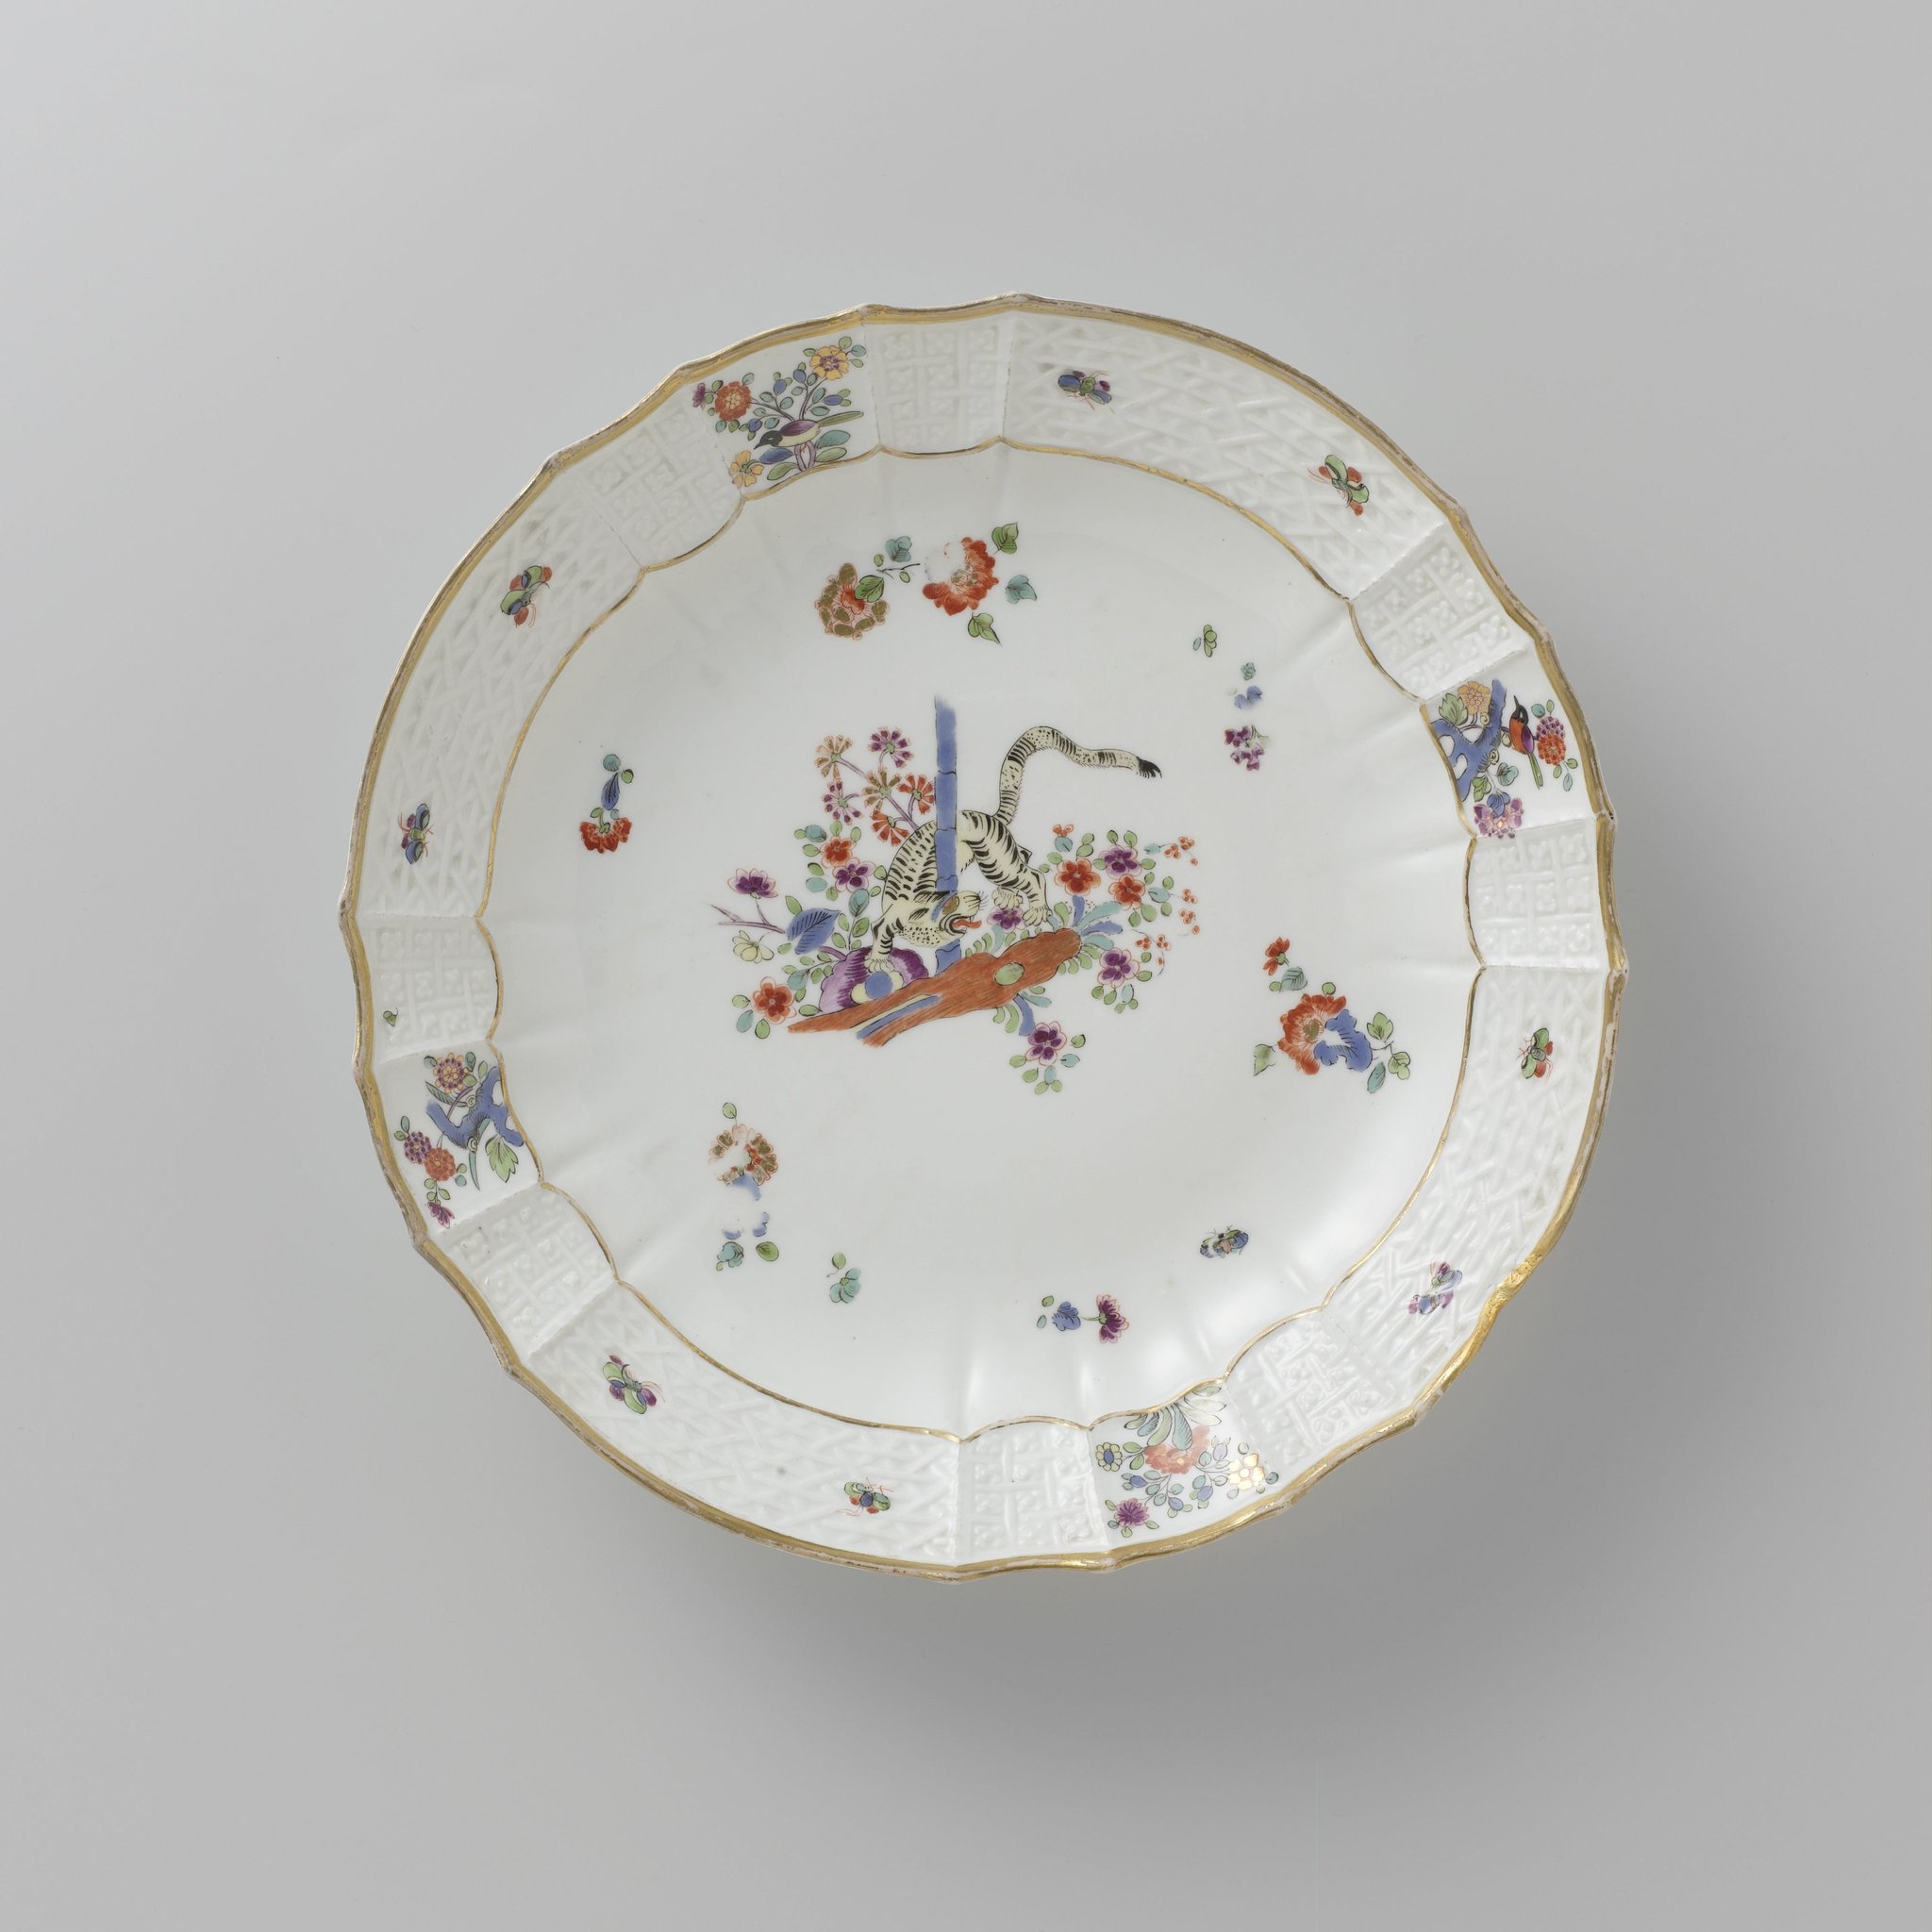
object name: platter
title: Schotel, veelkleurig beschilderd met een Kakiemon-decor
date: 1740-1745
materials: porcelain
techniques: painted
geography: meissen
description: Ronde schotel van beschilderd porselein. De schotel heeft een geribde en geschulpte rand. De schotel is beschilderd met een tijger om een bamboestengel, gestrooide Indianische Blumen, vlinders en takken met vogels. De rand is versierd met het 'Altbrandenstein'-patroon. De schotel is gemerkt.